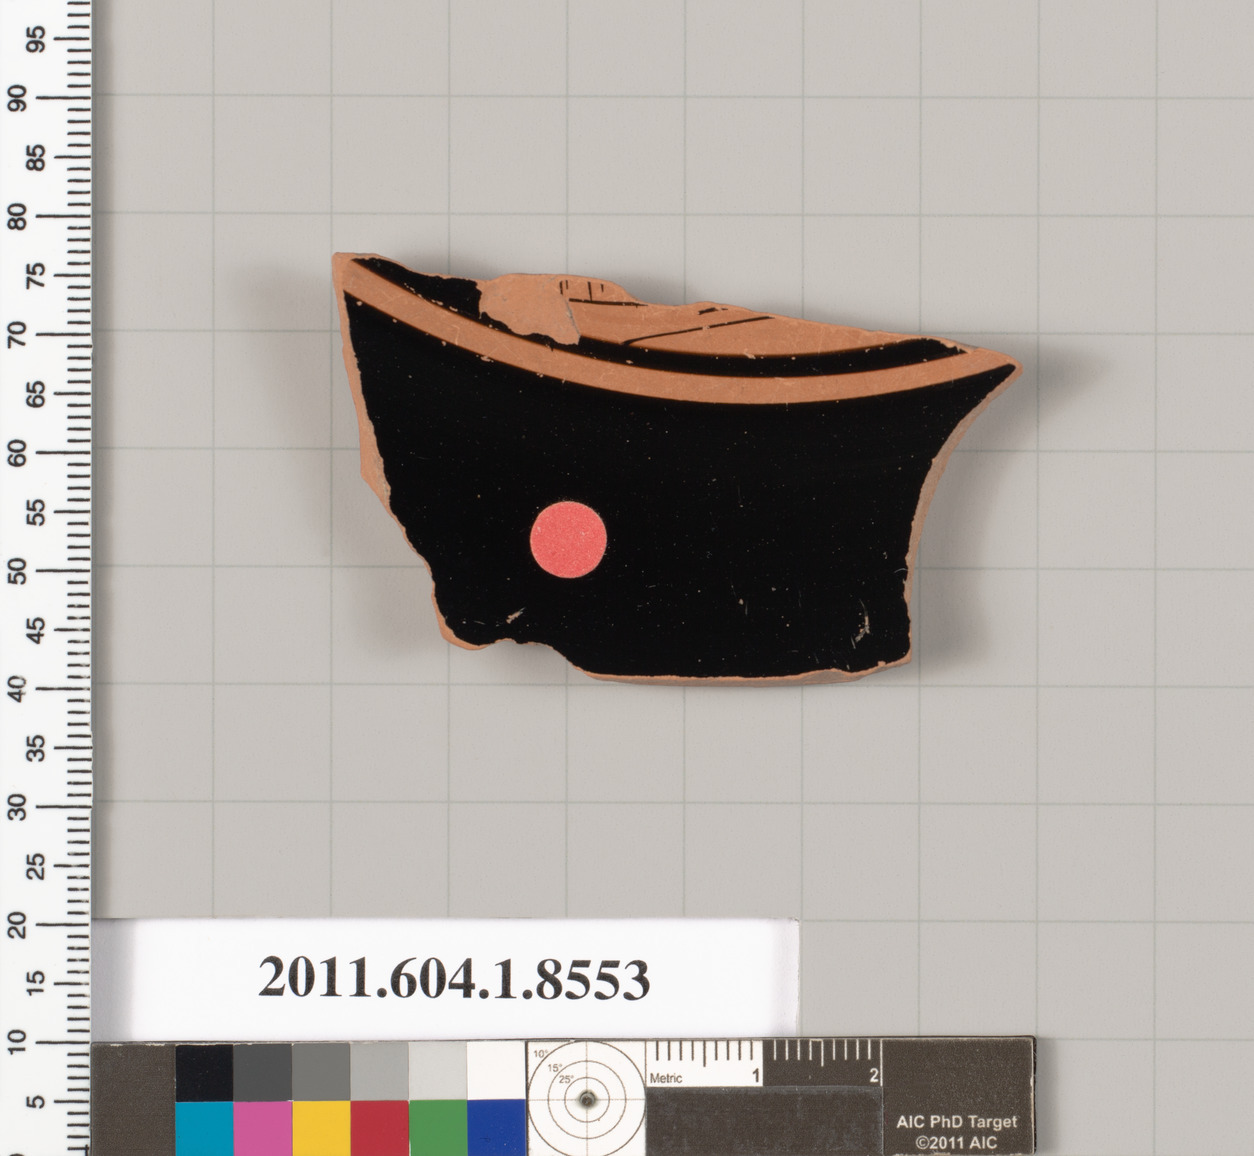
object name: kylix fragment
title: Terracotta fragment of a stemless kylix (drinking cup)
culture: greek, attic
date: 460-450 BCE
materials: terracotta